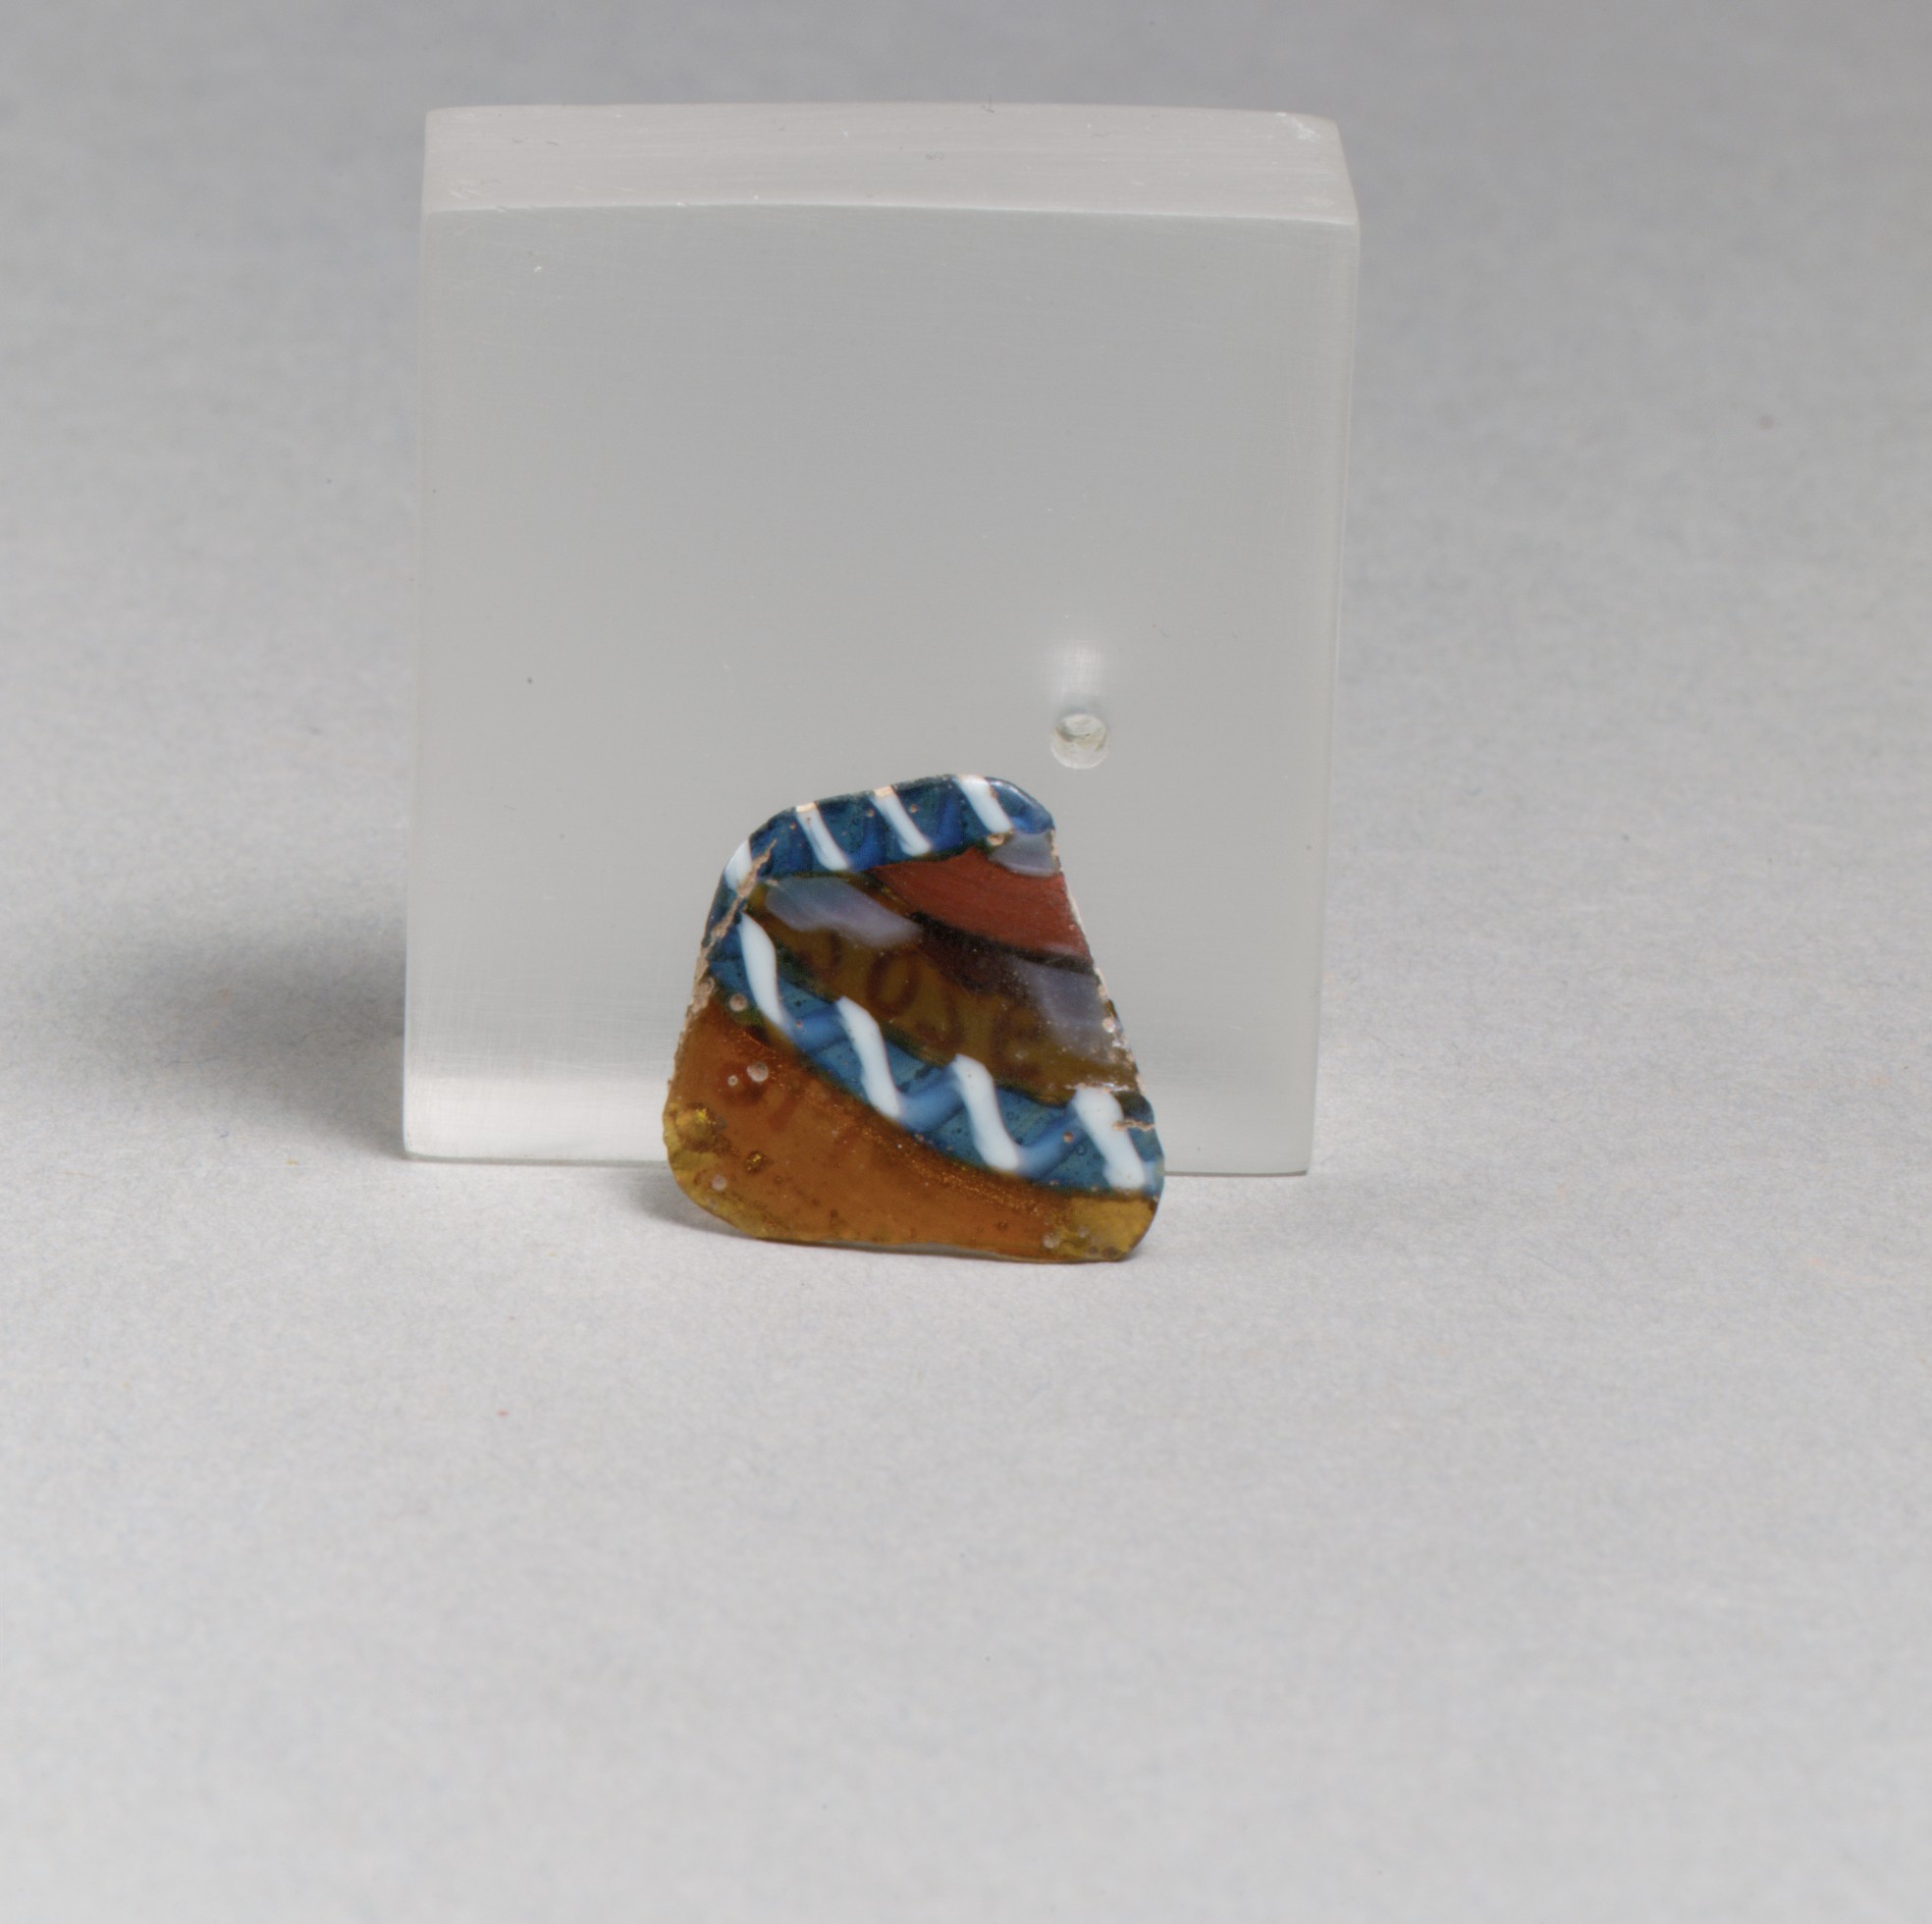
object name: fragment, striped mosaic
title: Glass striped mosaic bowl fragment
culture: roman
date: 34 BCE-33 CE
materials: glass